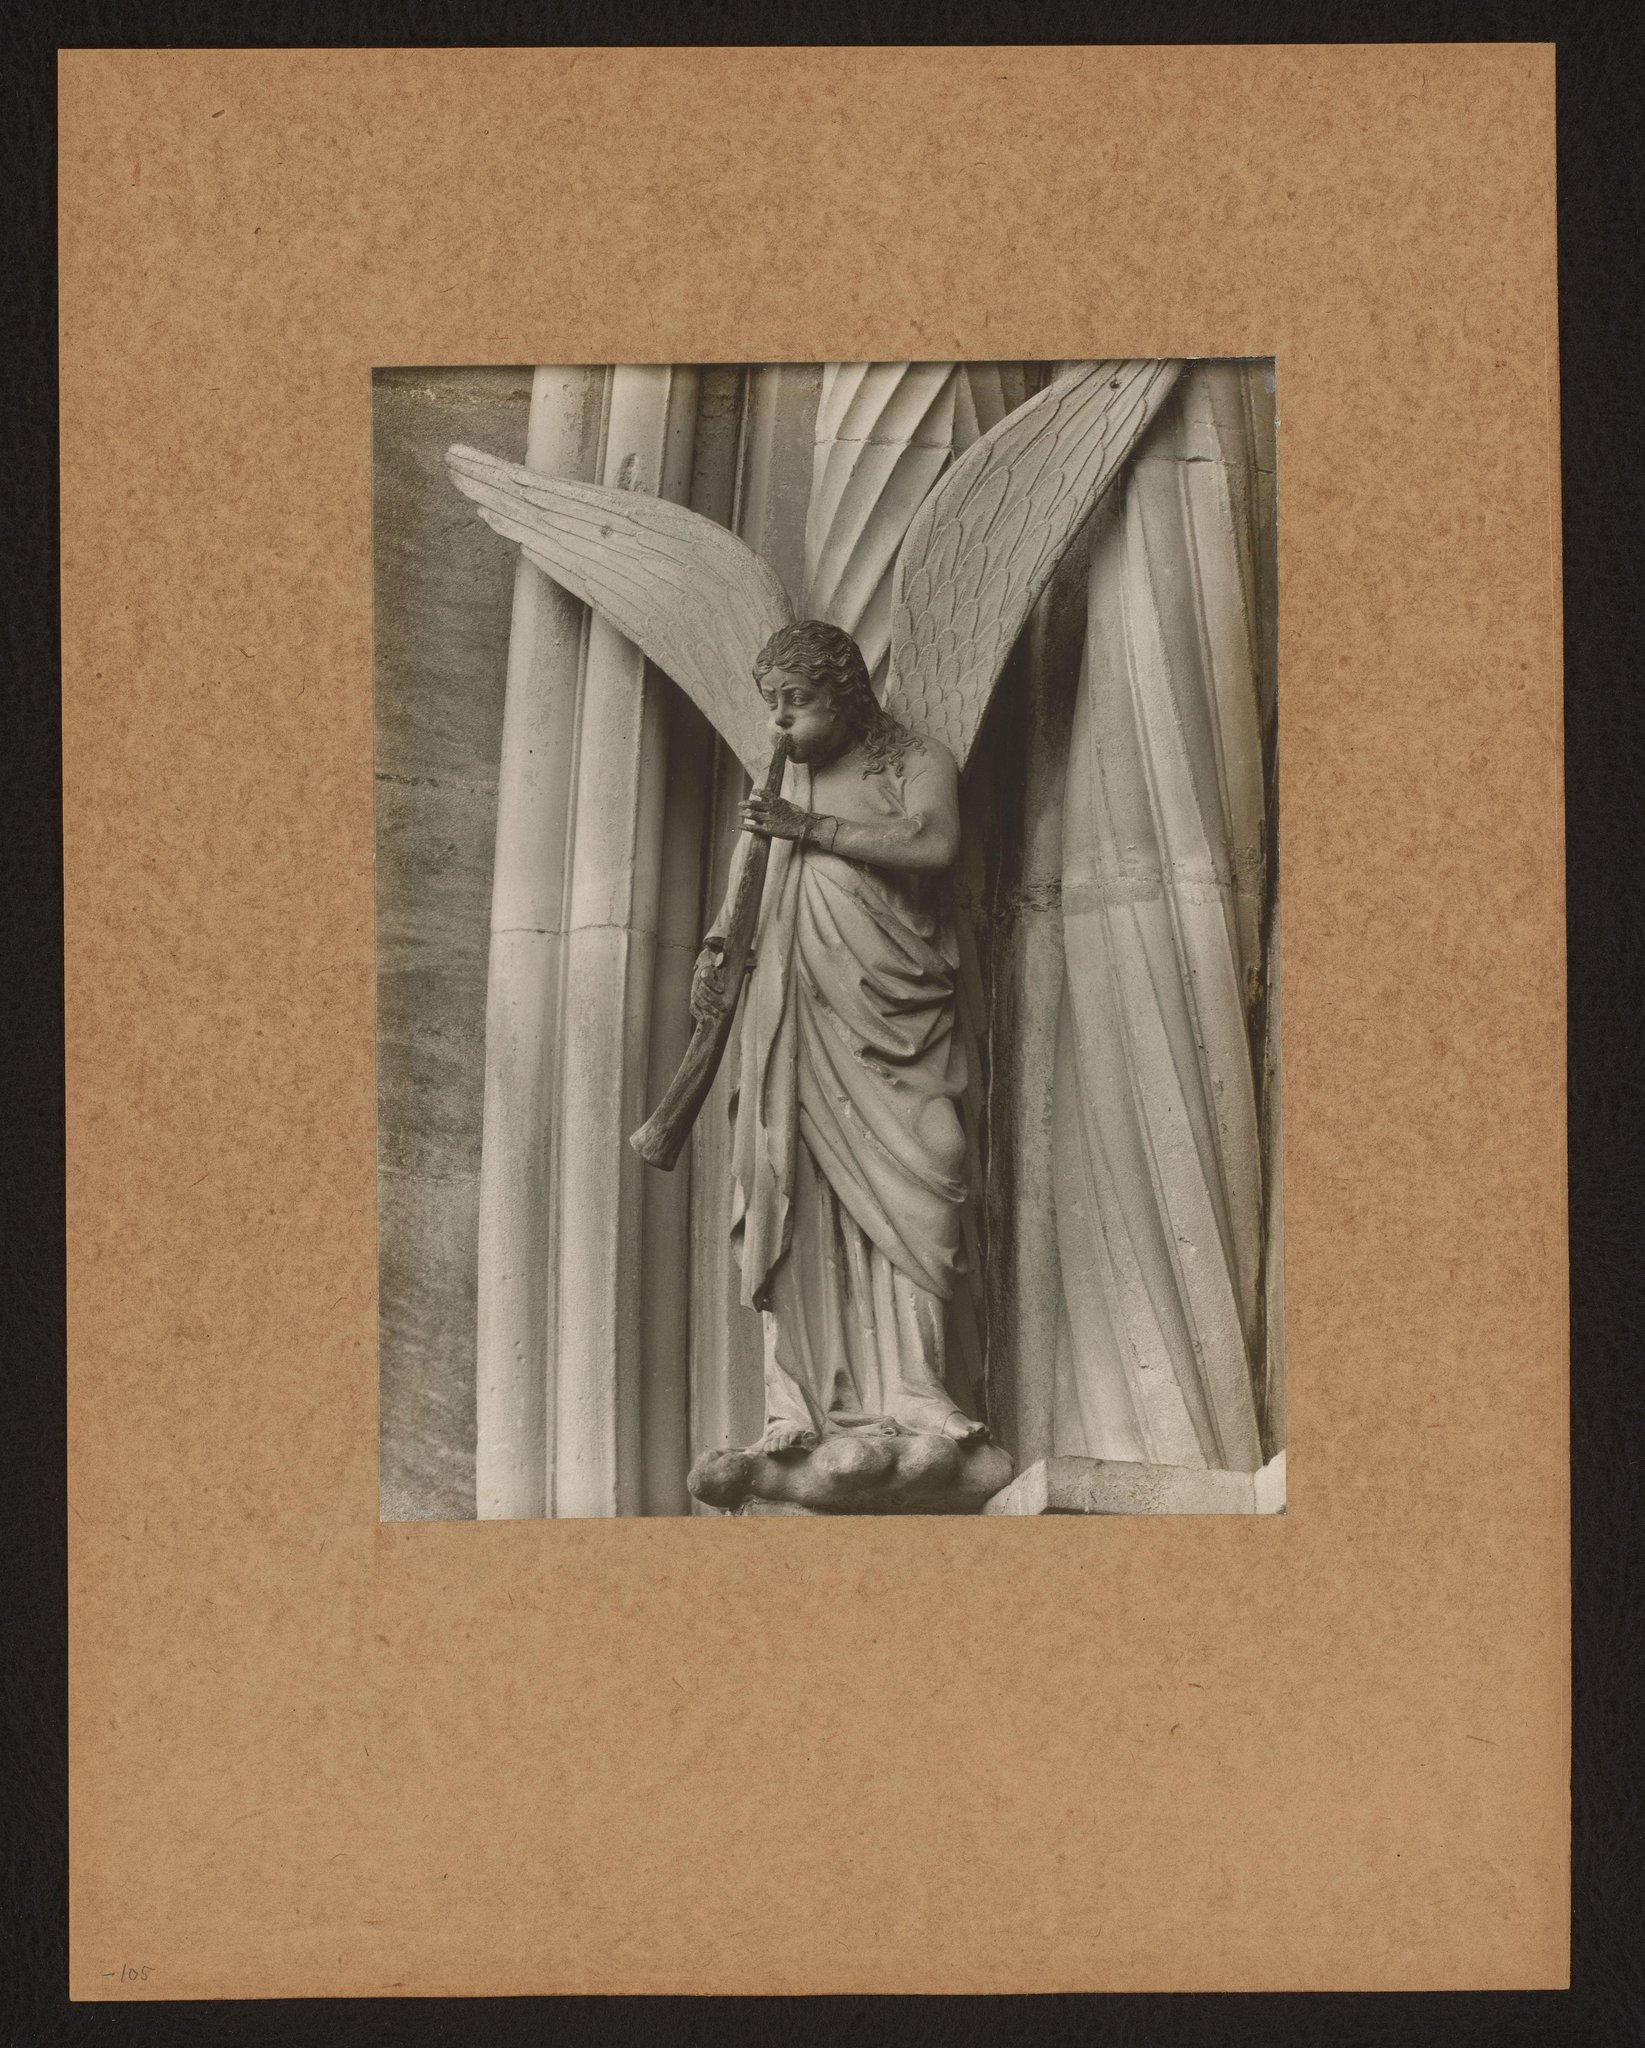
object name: album leaf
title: Detail van het Fürstenportal in de dom van Bamberg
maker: Anonymous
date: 1900-1920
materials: paper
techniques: gelatin silver print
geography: bamberg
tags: church (exterior)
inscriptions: number: ‘108’